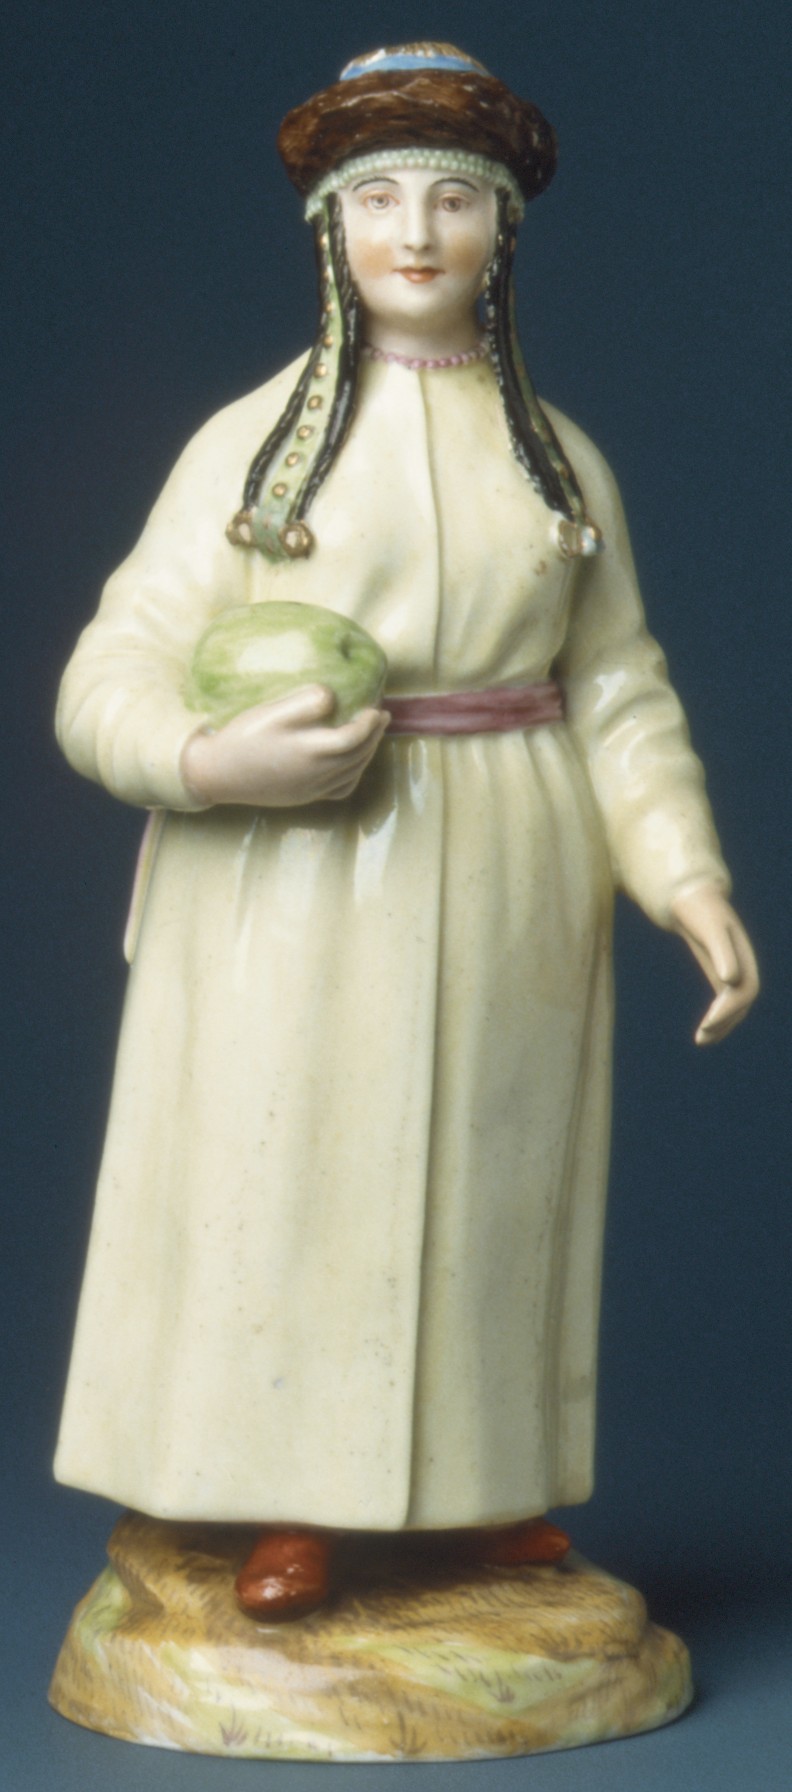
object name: figure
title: Tatar Woman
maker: imperial porcelain manufactory, st. petersburg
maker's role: manufactory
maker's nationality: russian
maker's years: 1744-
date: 1780-1800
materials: hard paste porcelain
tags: women